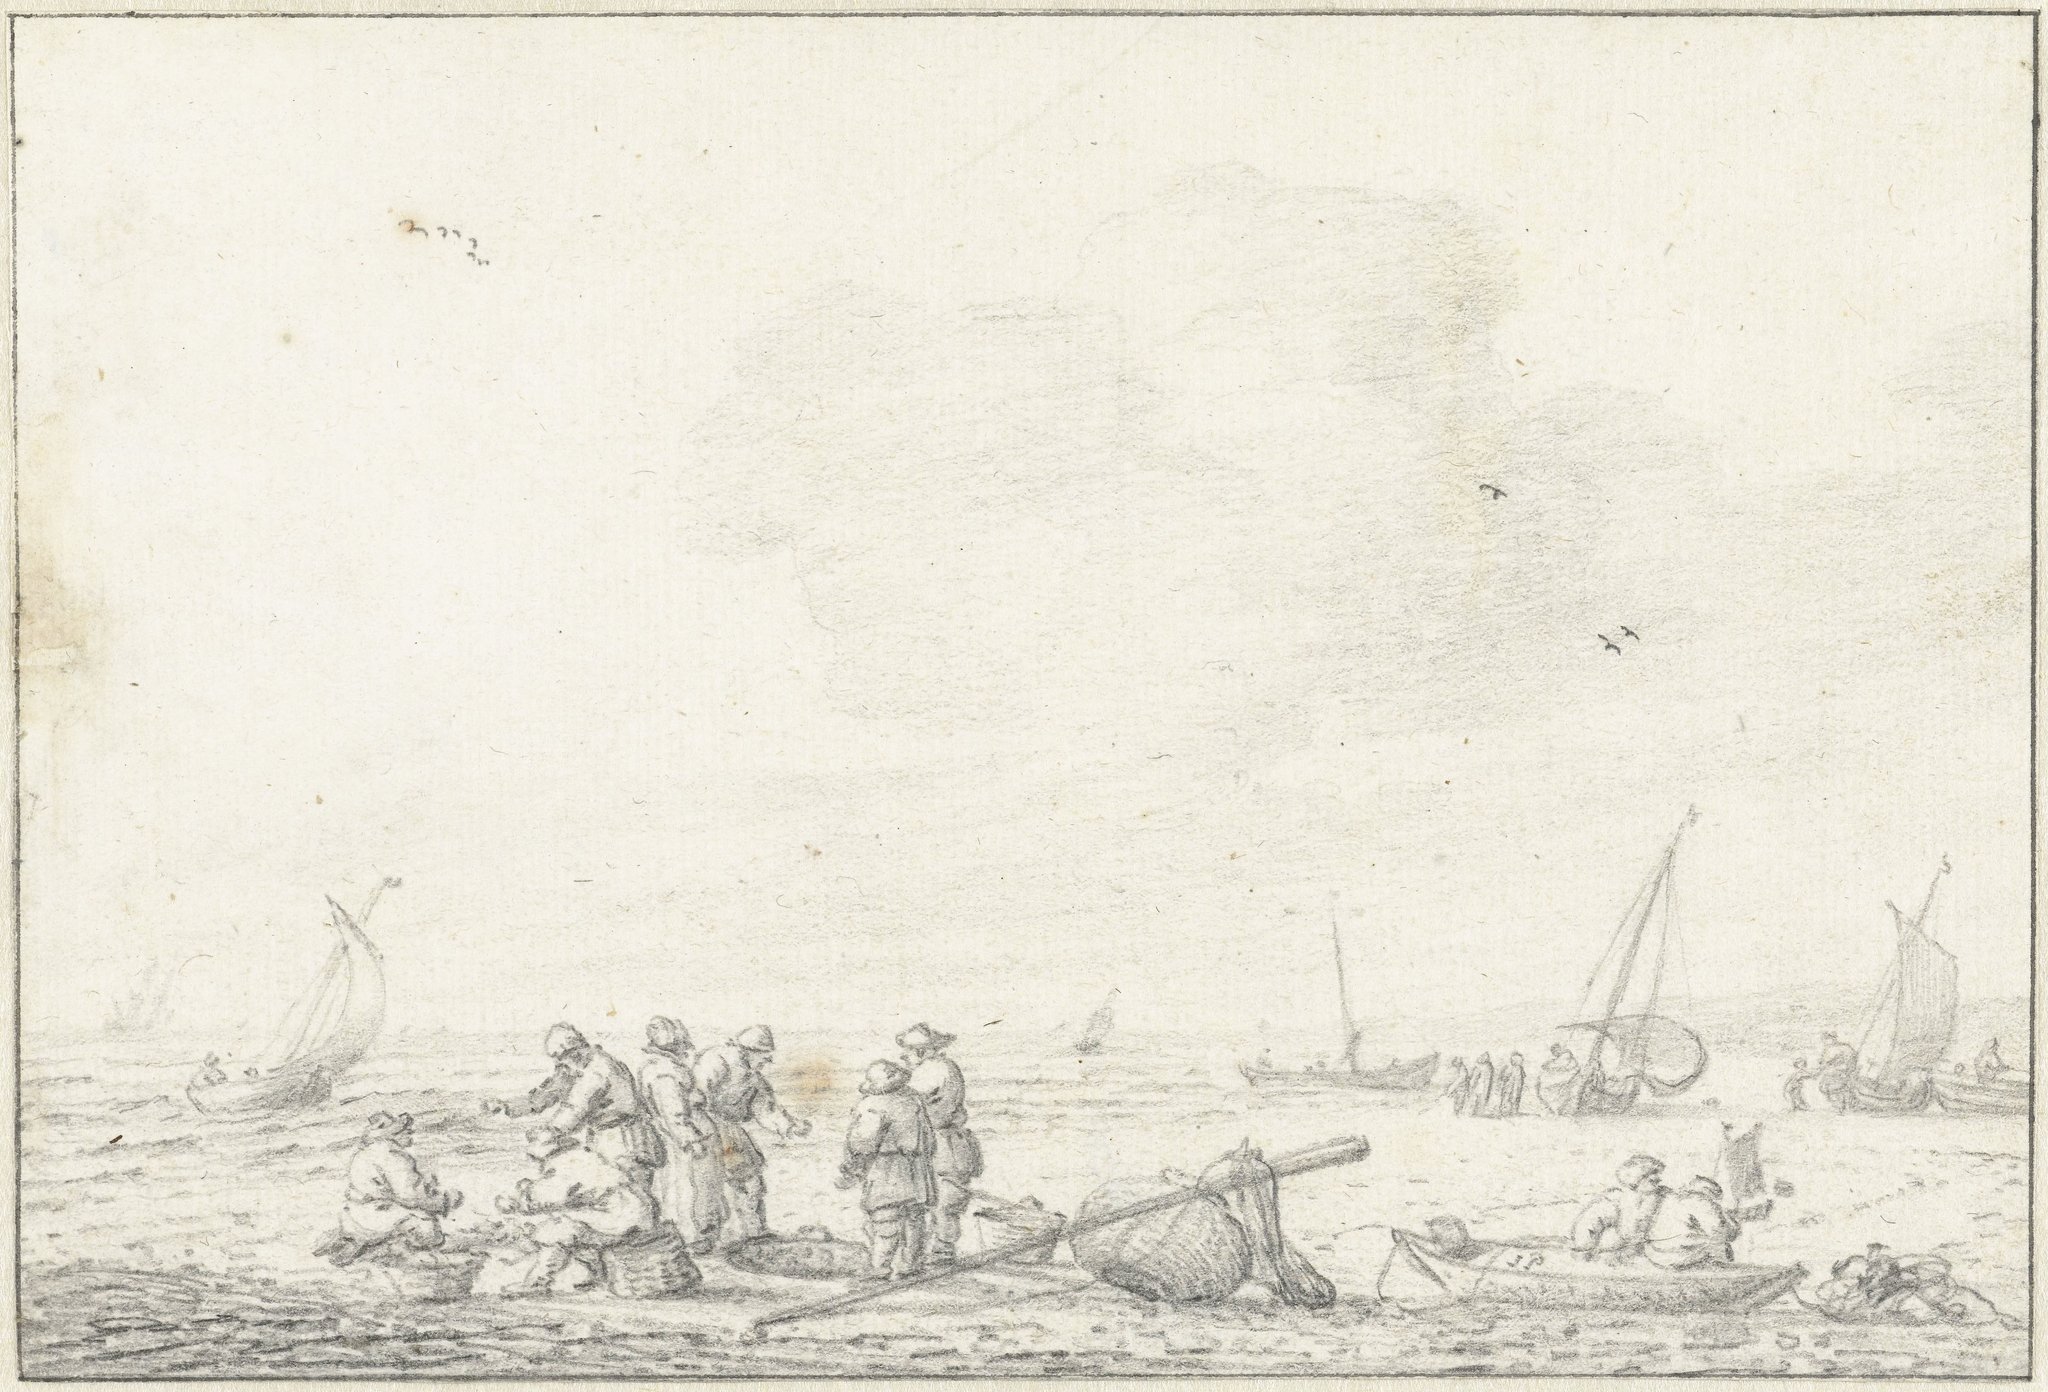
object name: drawing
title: Strandgezicht met op de voorgrond een groep vissers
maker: jan porcellis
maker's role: draughtsman, painter, print maker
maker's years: 1584-1632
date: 1594-1632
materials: paper, pencil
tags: beach, sea and coastal fishery